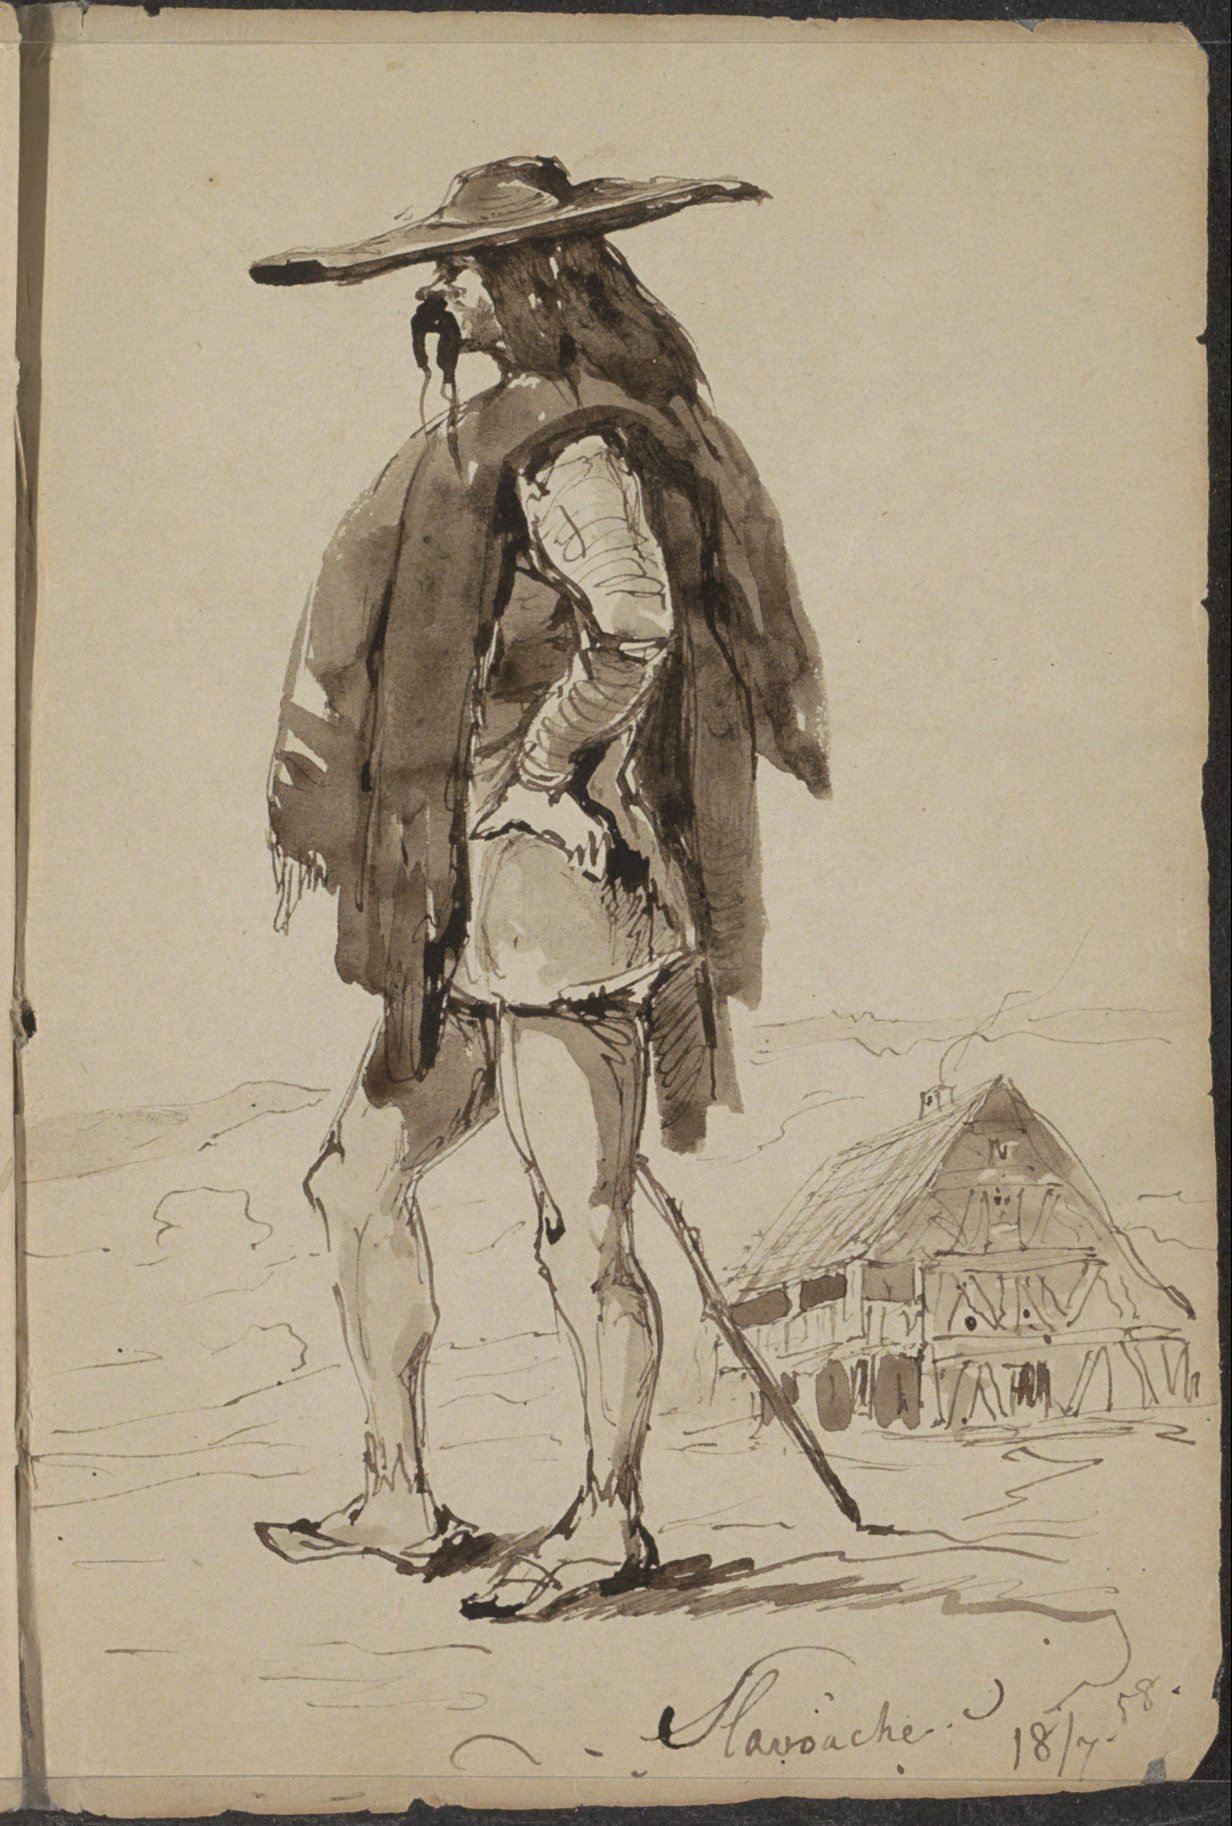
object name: sketchbook leaf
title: Landschap met een herder bij een vakwerkhuis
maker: johannes tavenraat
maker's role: draughtsman, painter, print maker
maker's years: 1809-1881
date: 1807-1858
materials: ink, paper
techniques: brush, pen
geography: bohemia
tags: herding, herdsman, herdswoman, shepherd, shepherdess, cowherd, etc., walking-stick, staff, rural housing, e.g. country-house, villa, cottage, landscapes (+ landscape with figures, staffage)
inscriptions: date and inscription: ‘[...]lavoache/ 18/7 58.’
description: De man, vermoedelijk een herder, draagt een hoed, wandelstok en een mantel. Blad 44 recto uit een schetsboek met 44 bladen.